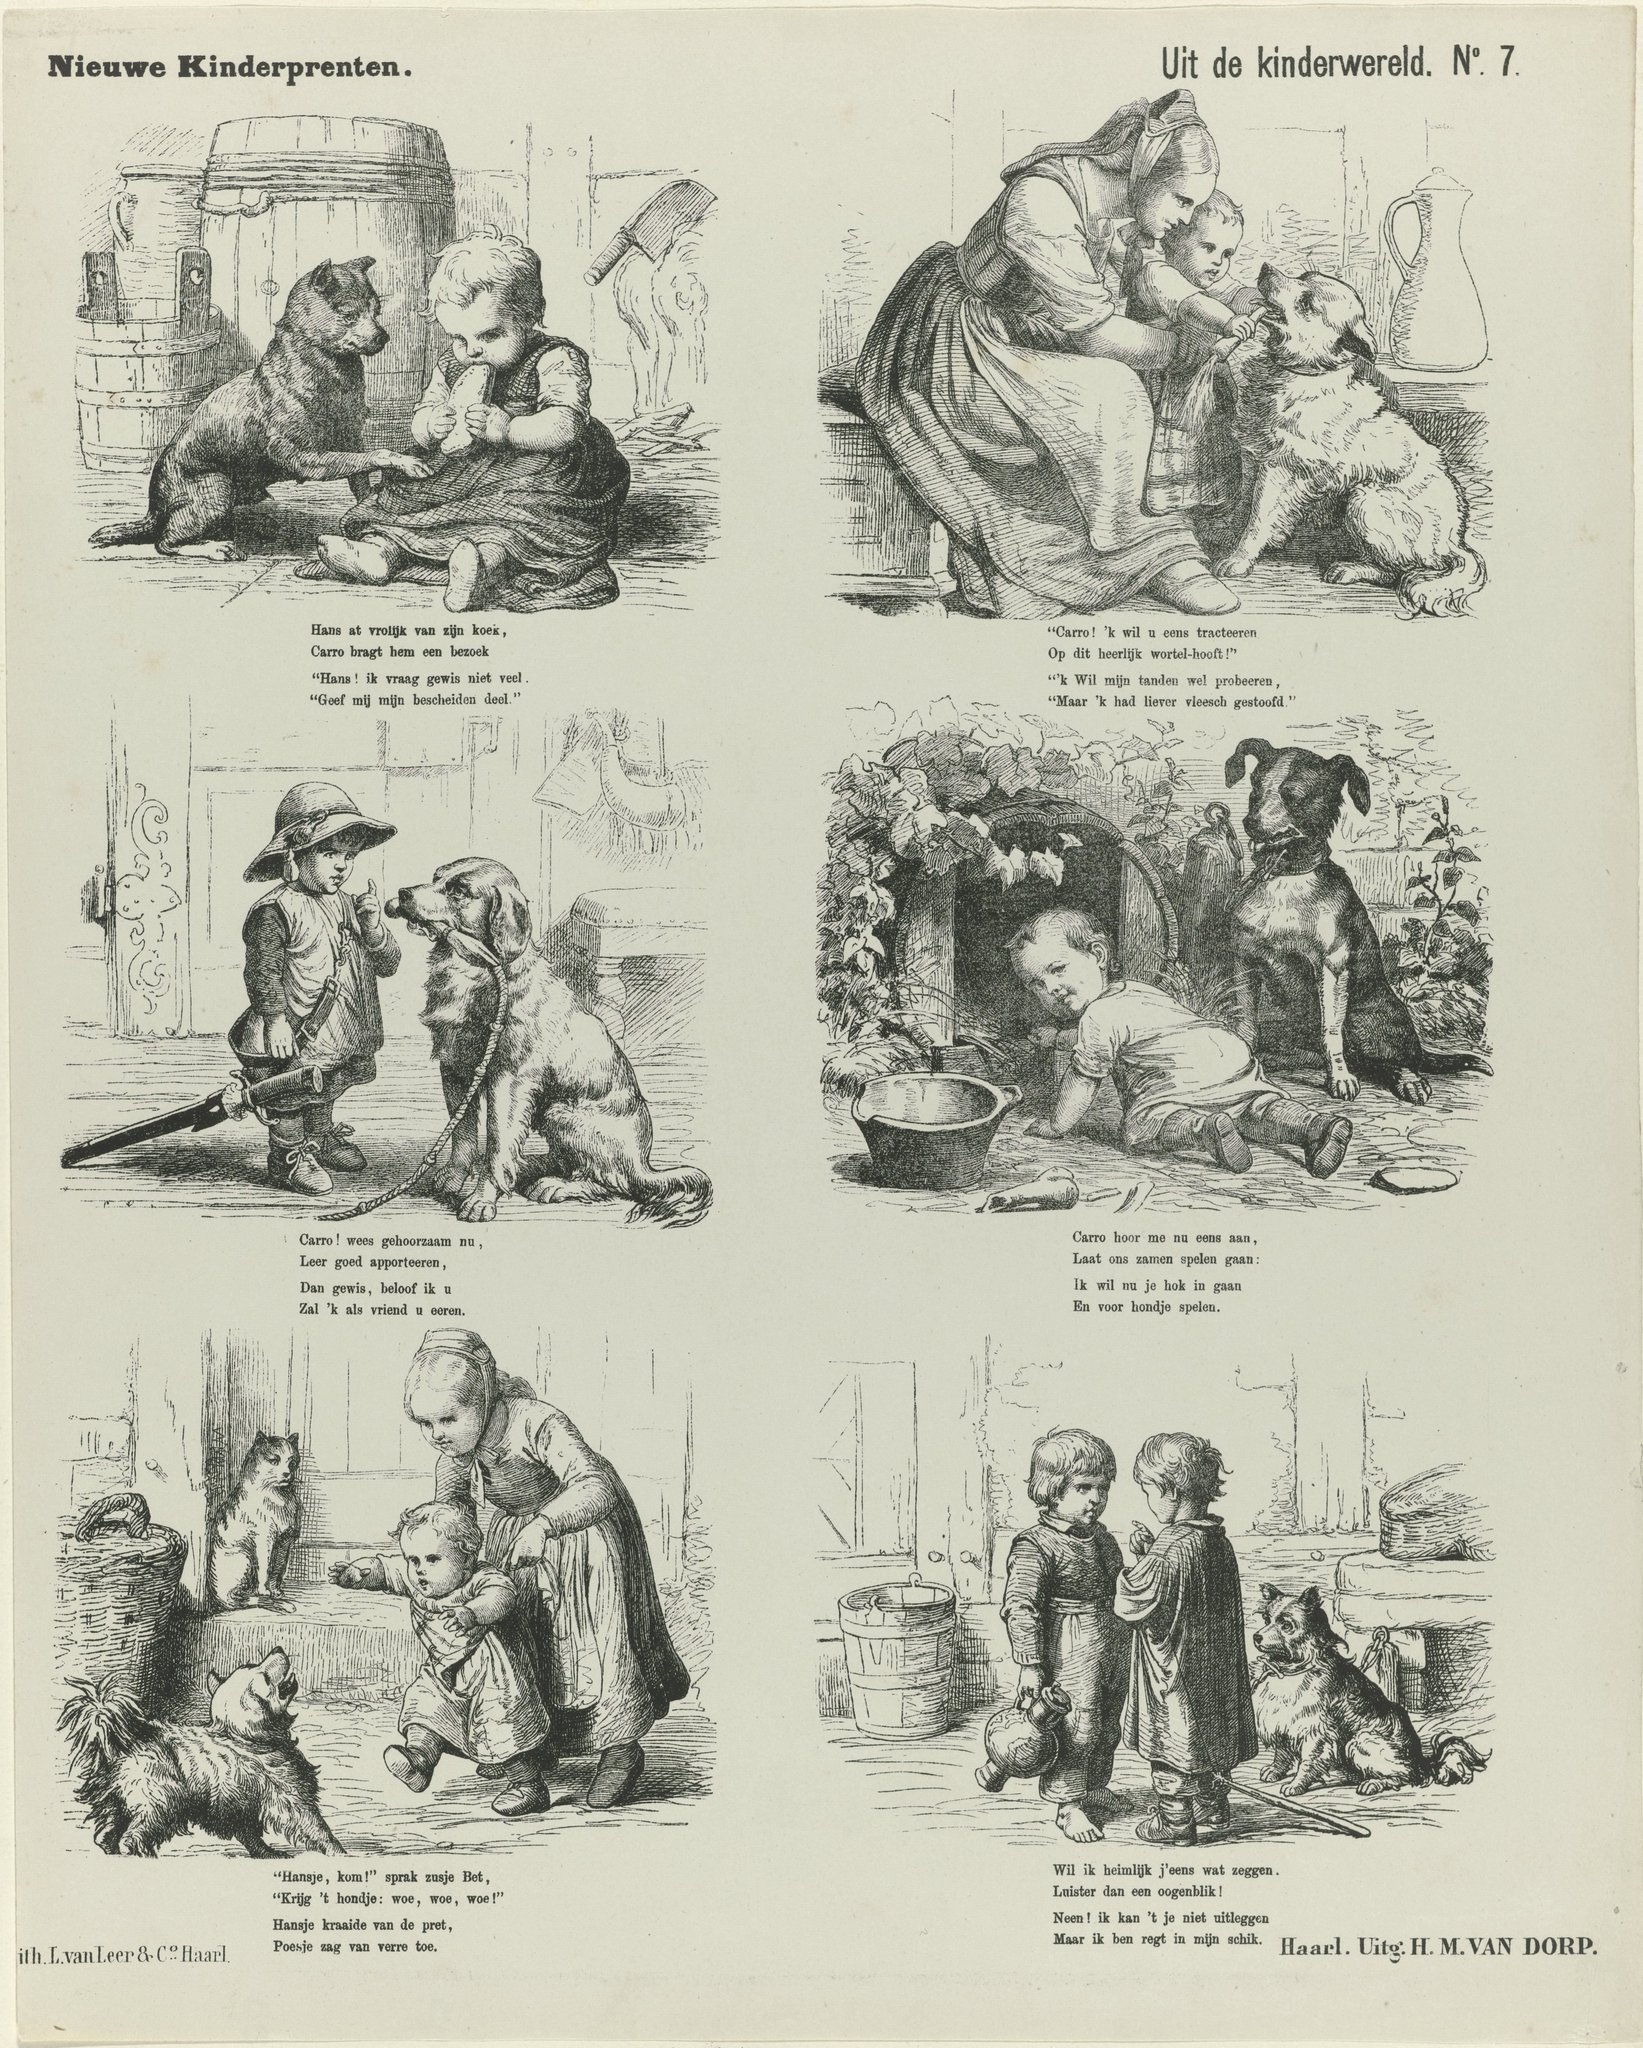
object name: print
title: Uit de kinderwereld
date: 1872-1883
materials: paper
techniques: letterpress printing, lithograph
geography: haarlem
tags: child, child playing with animals, dog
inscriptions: collector's mark: Lugt 2760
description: Blad met 6 voorstellingen van kinderen met honden. Onder elke voorstelling een vierregelig vers. Genummerd rechtsboven: No. 7.